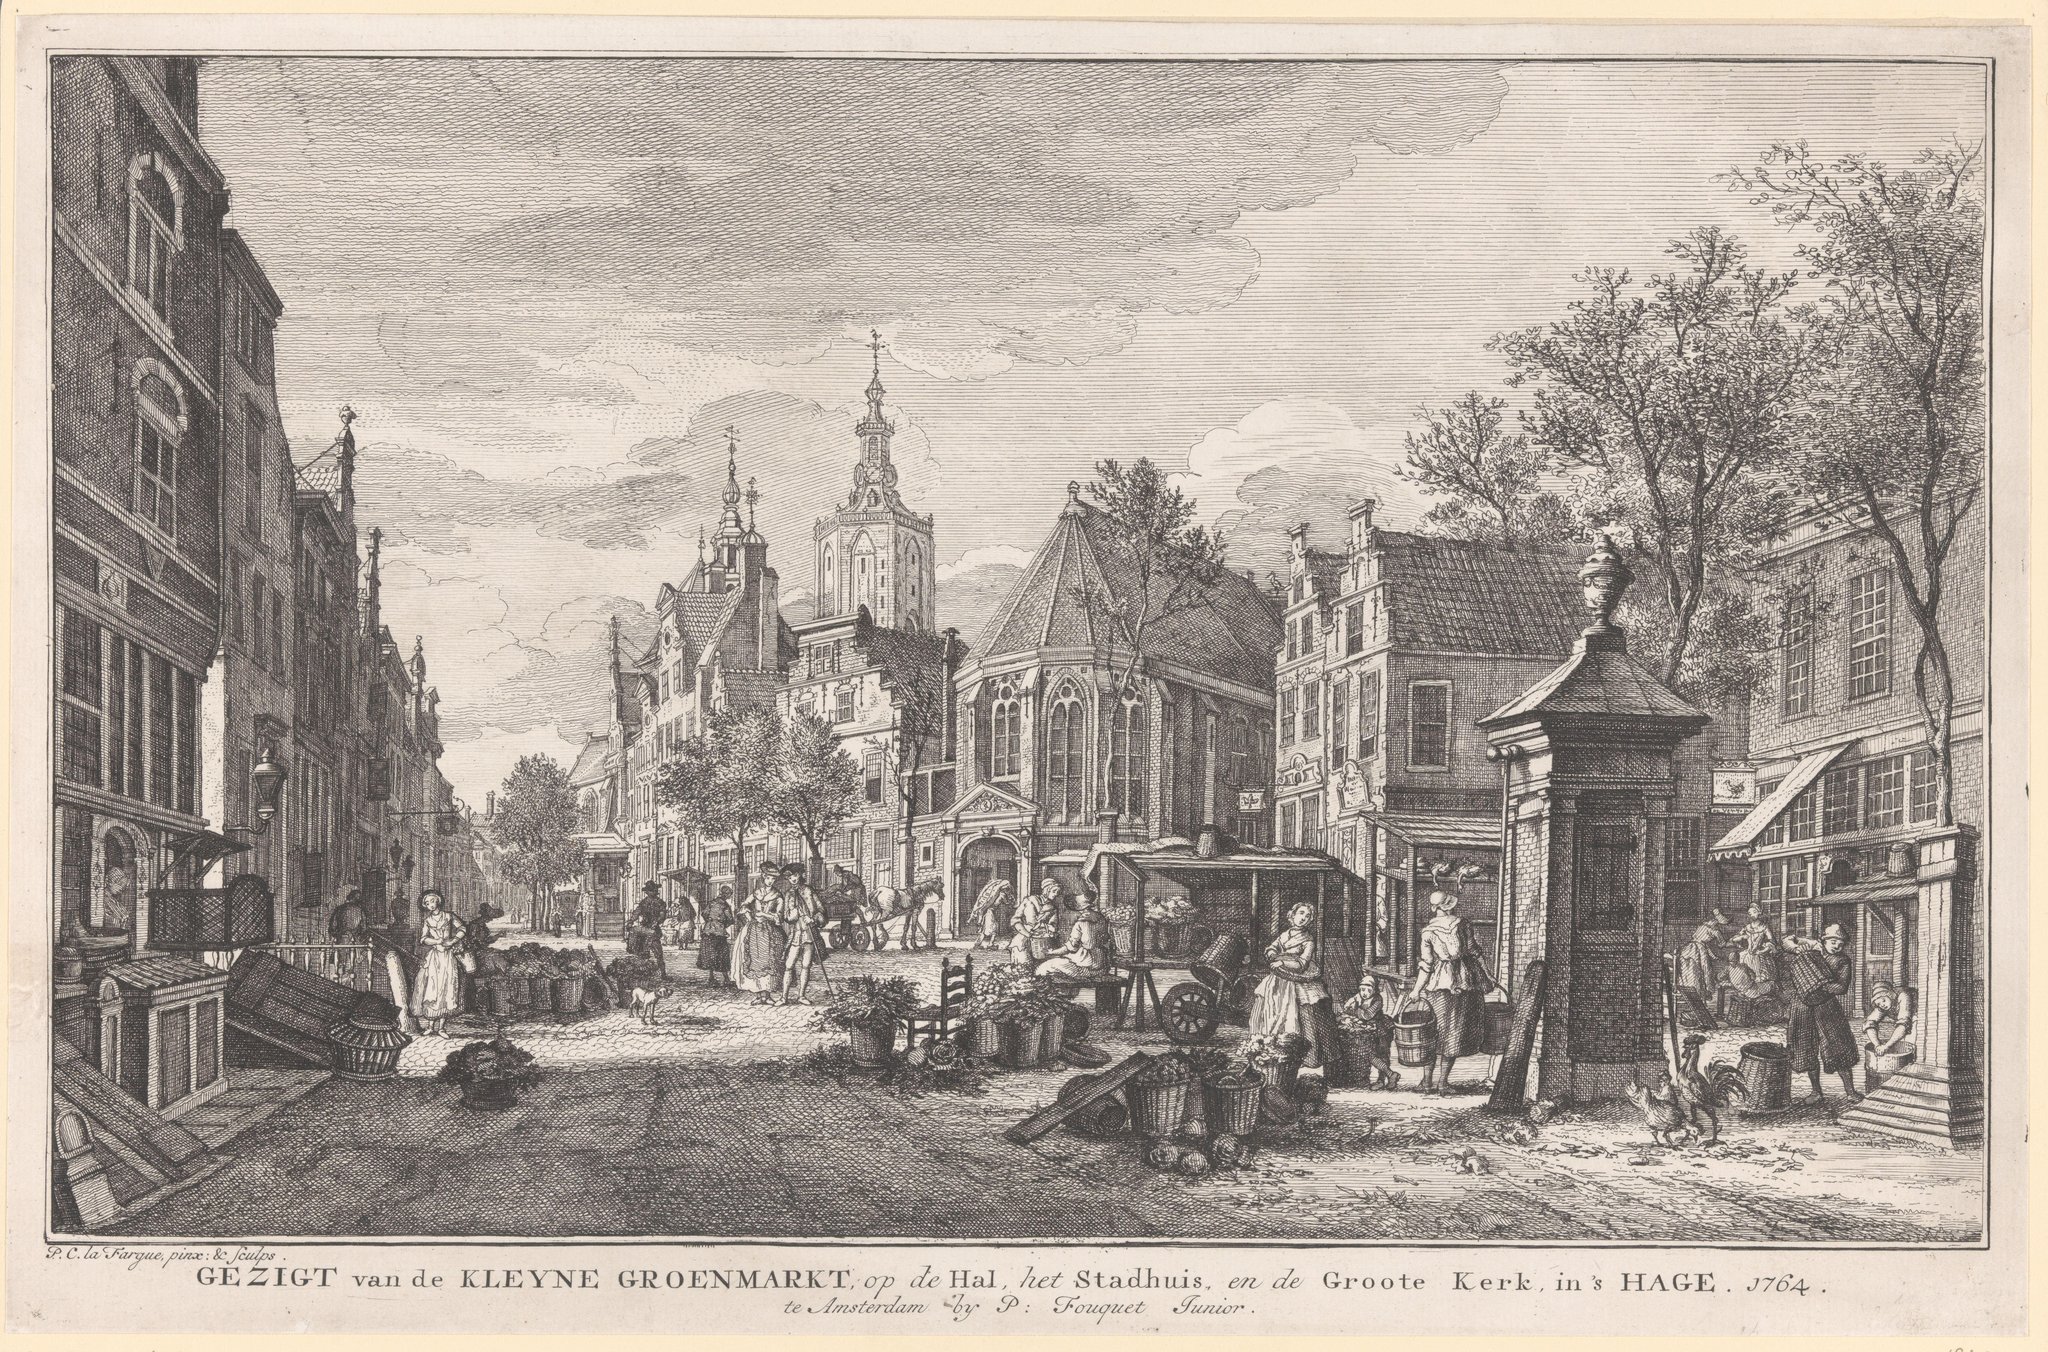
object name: print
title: Gezigt van de Kleyne Groenmarkt, op de Hal, het Stadhuis, en de Groote Kerk, in ’s Hage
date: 1764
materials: paper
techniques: engraving, etching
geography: amsterdam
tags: vegetables, city-view, and landscape with man-made constructions, stall, booth (~ market), church (exterior), townhall, market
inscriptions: collector's mark: Lugt 2228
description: Gezicht op de Dagelijkse Groenmarkt te Den Haag met op de voorgrond een groentestal en kopers. In het midden de Vleeshal in de voormalige Sint-Nicolaaskapel, waar een figuur een geslachte koe naar binnen brengt. Op de achtergrond links van het midden het Oude Stadhuis en de toren van de Grote Kerk. Prent uit een serie van acht gezichten in Den Haag.